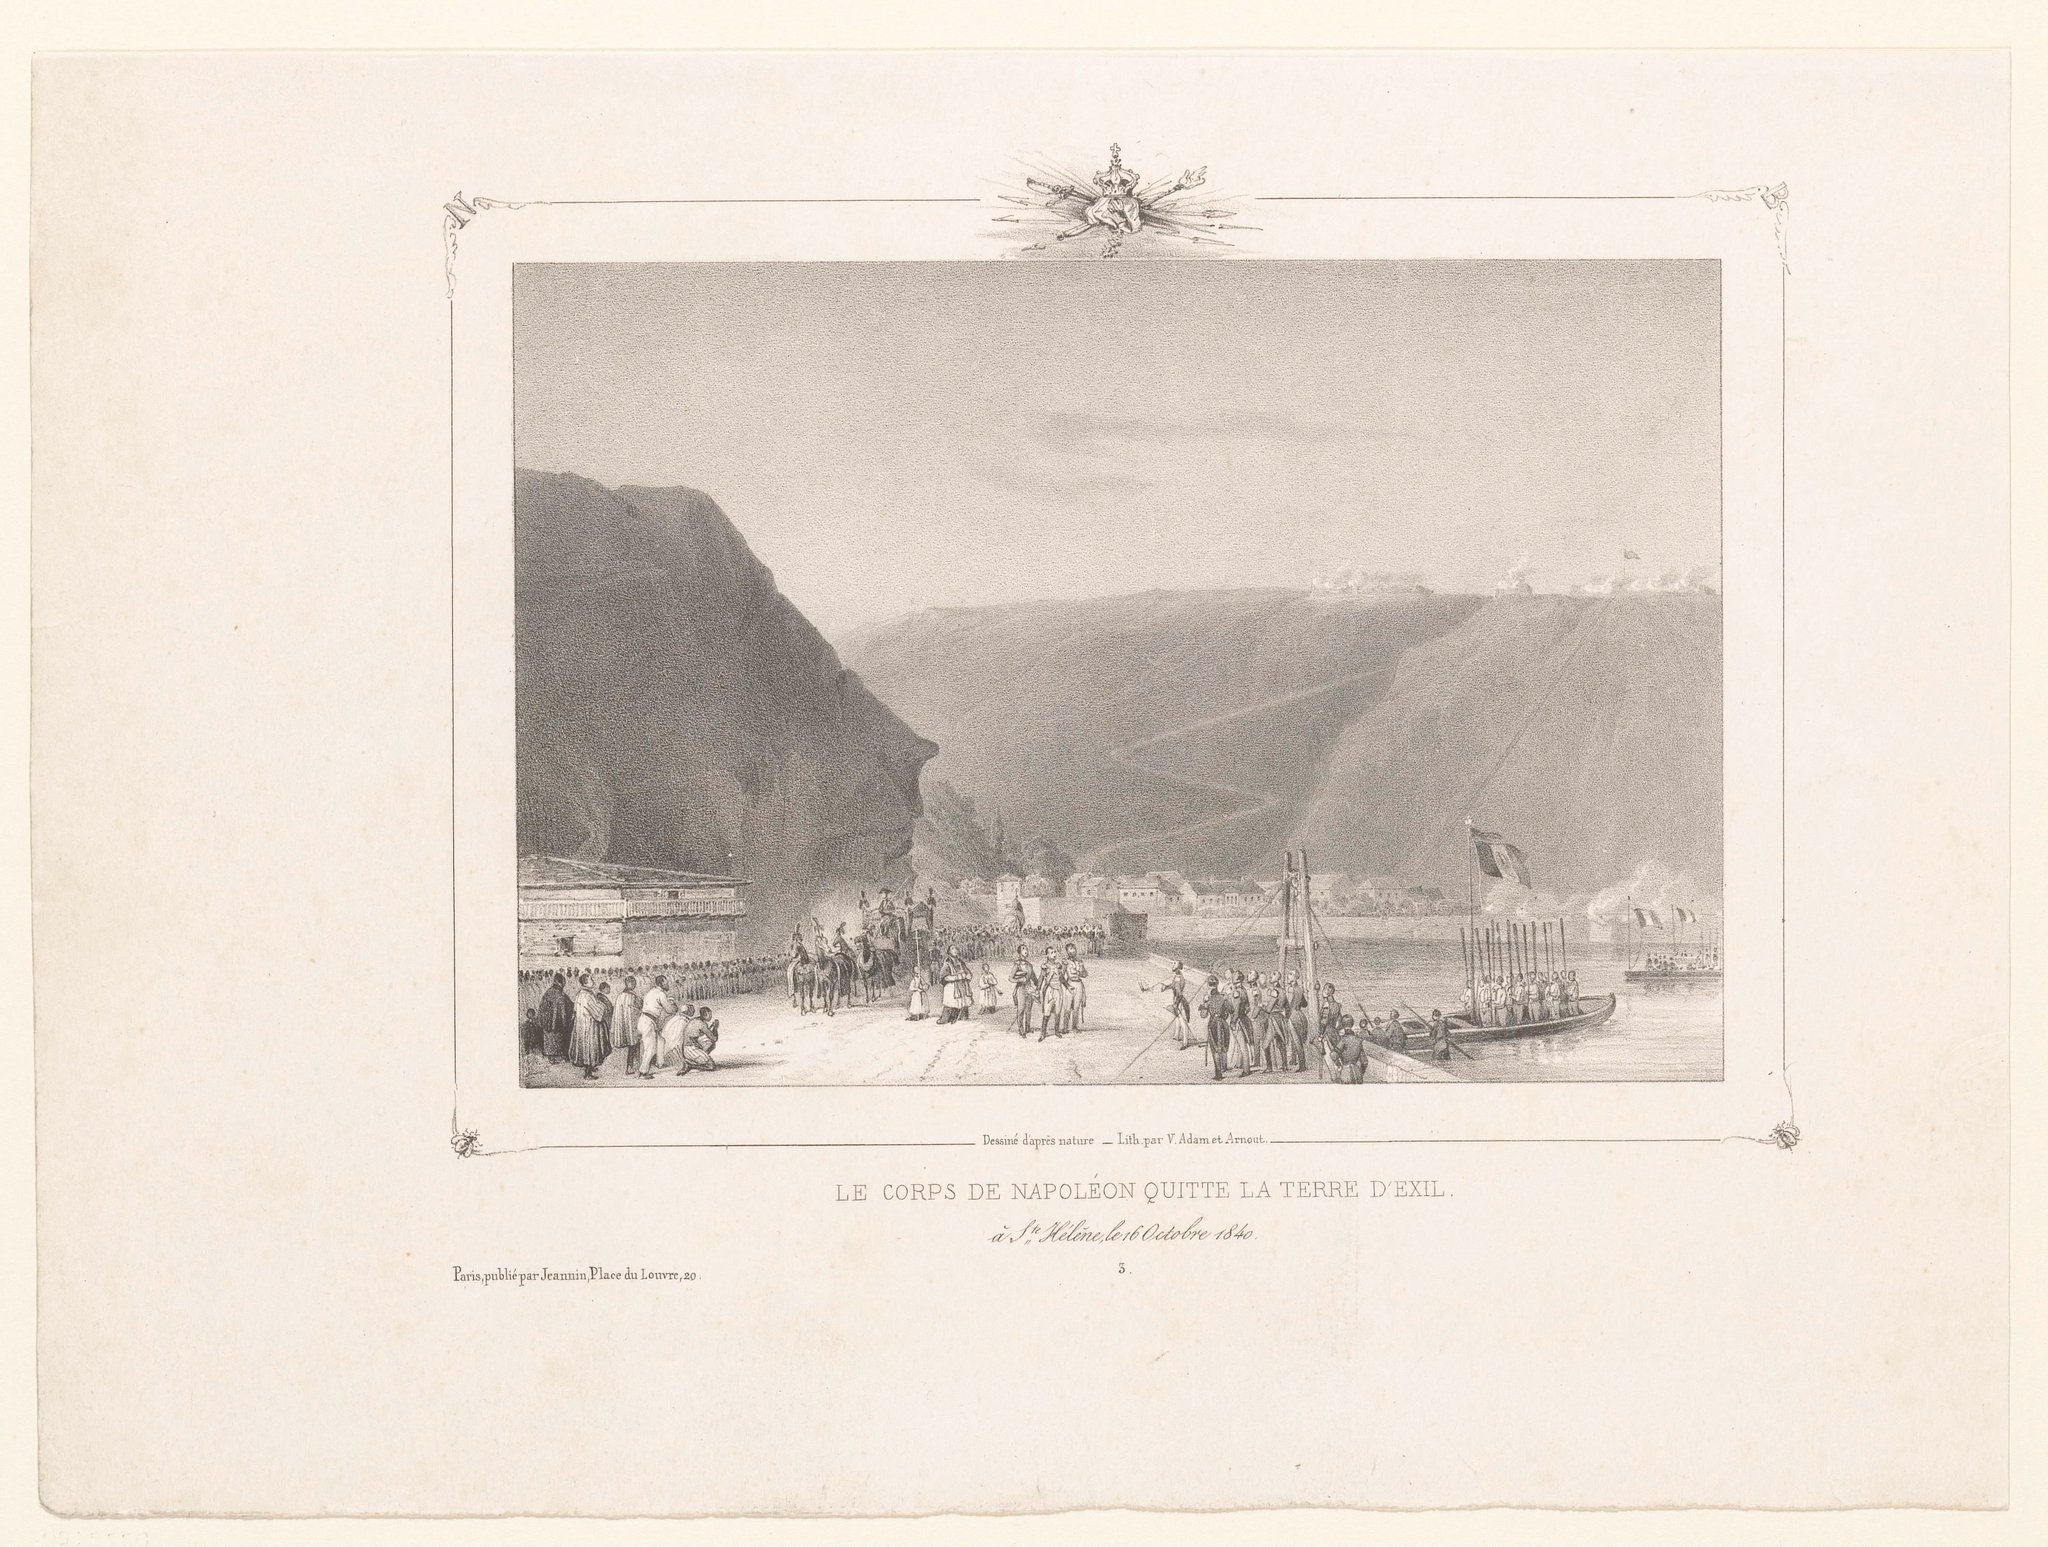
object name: print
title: Napoleons lichaam verlaat het eiland Sint-Helena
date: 1840-1841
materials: paper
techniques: lithograph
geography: paris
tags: napoleon i (emperor of the french), re-burial, coffin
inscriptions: stamp: Lugt 1397c, collector's mark: Lugt 2228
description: Deze serie bevat 24 prenten in klein formaat, die een vereenvoudiging zijn van eerder uitgegeven prenten in groot formaat. In 1840 werden de stoffelijke resten van Napoleon op initiatief van Adolphe Thiers en koning Louis-Philippe van Sint-Helena overgebracht naar Parijs (Le retour des cendres). De tekening voor de steendruk is naar het leven gemaakt ('dessiné d'après nature').